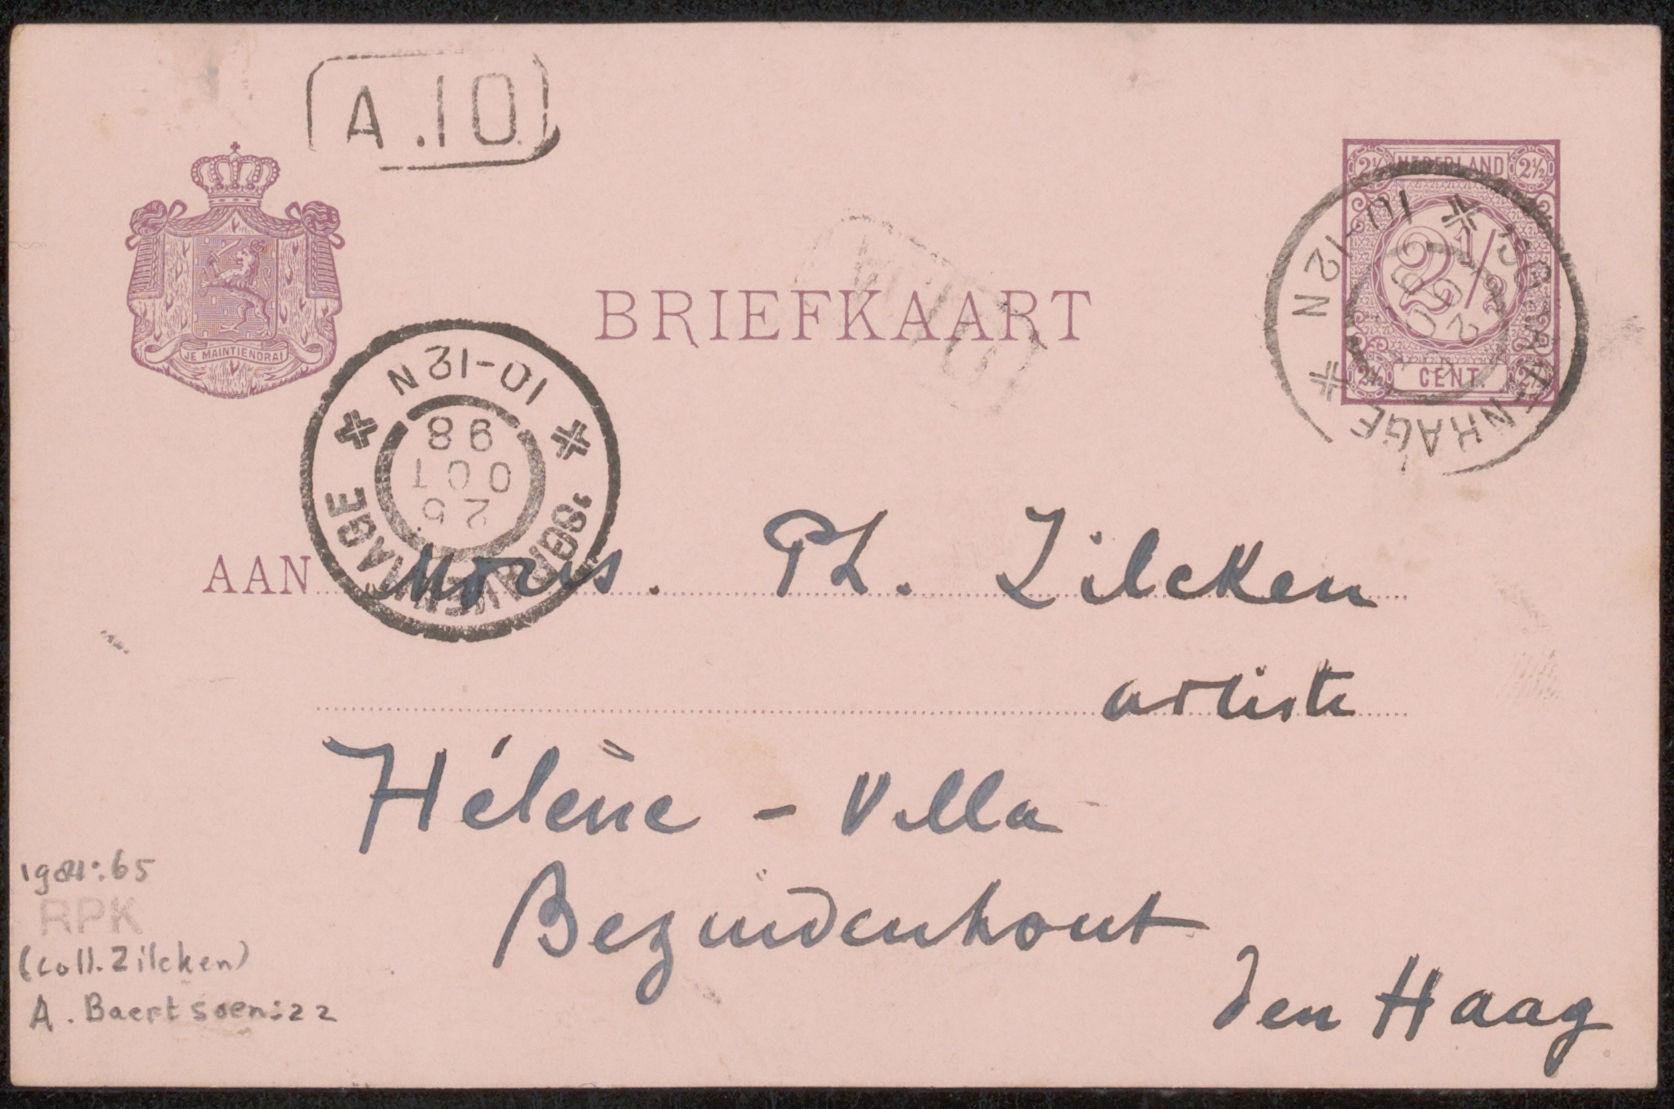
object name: postcard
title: Briefkaart aan Philip Zilcken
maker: albert baertsoen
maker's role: draughtsman, print maker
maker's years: 1866-1922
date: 1898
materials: cardboard, ink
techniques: pen, writing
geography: the hague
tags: painter, draughtsman, philip zilcken, the hague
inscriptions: collector's mark: ‘RPK’